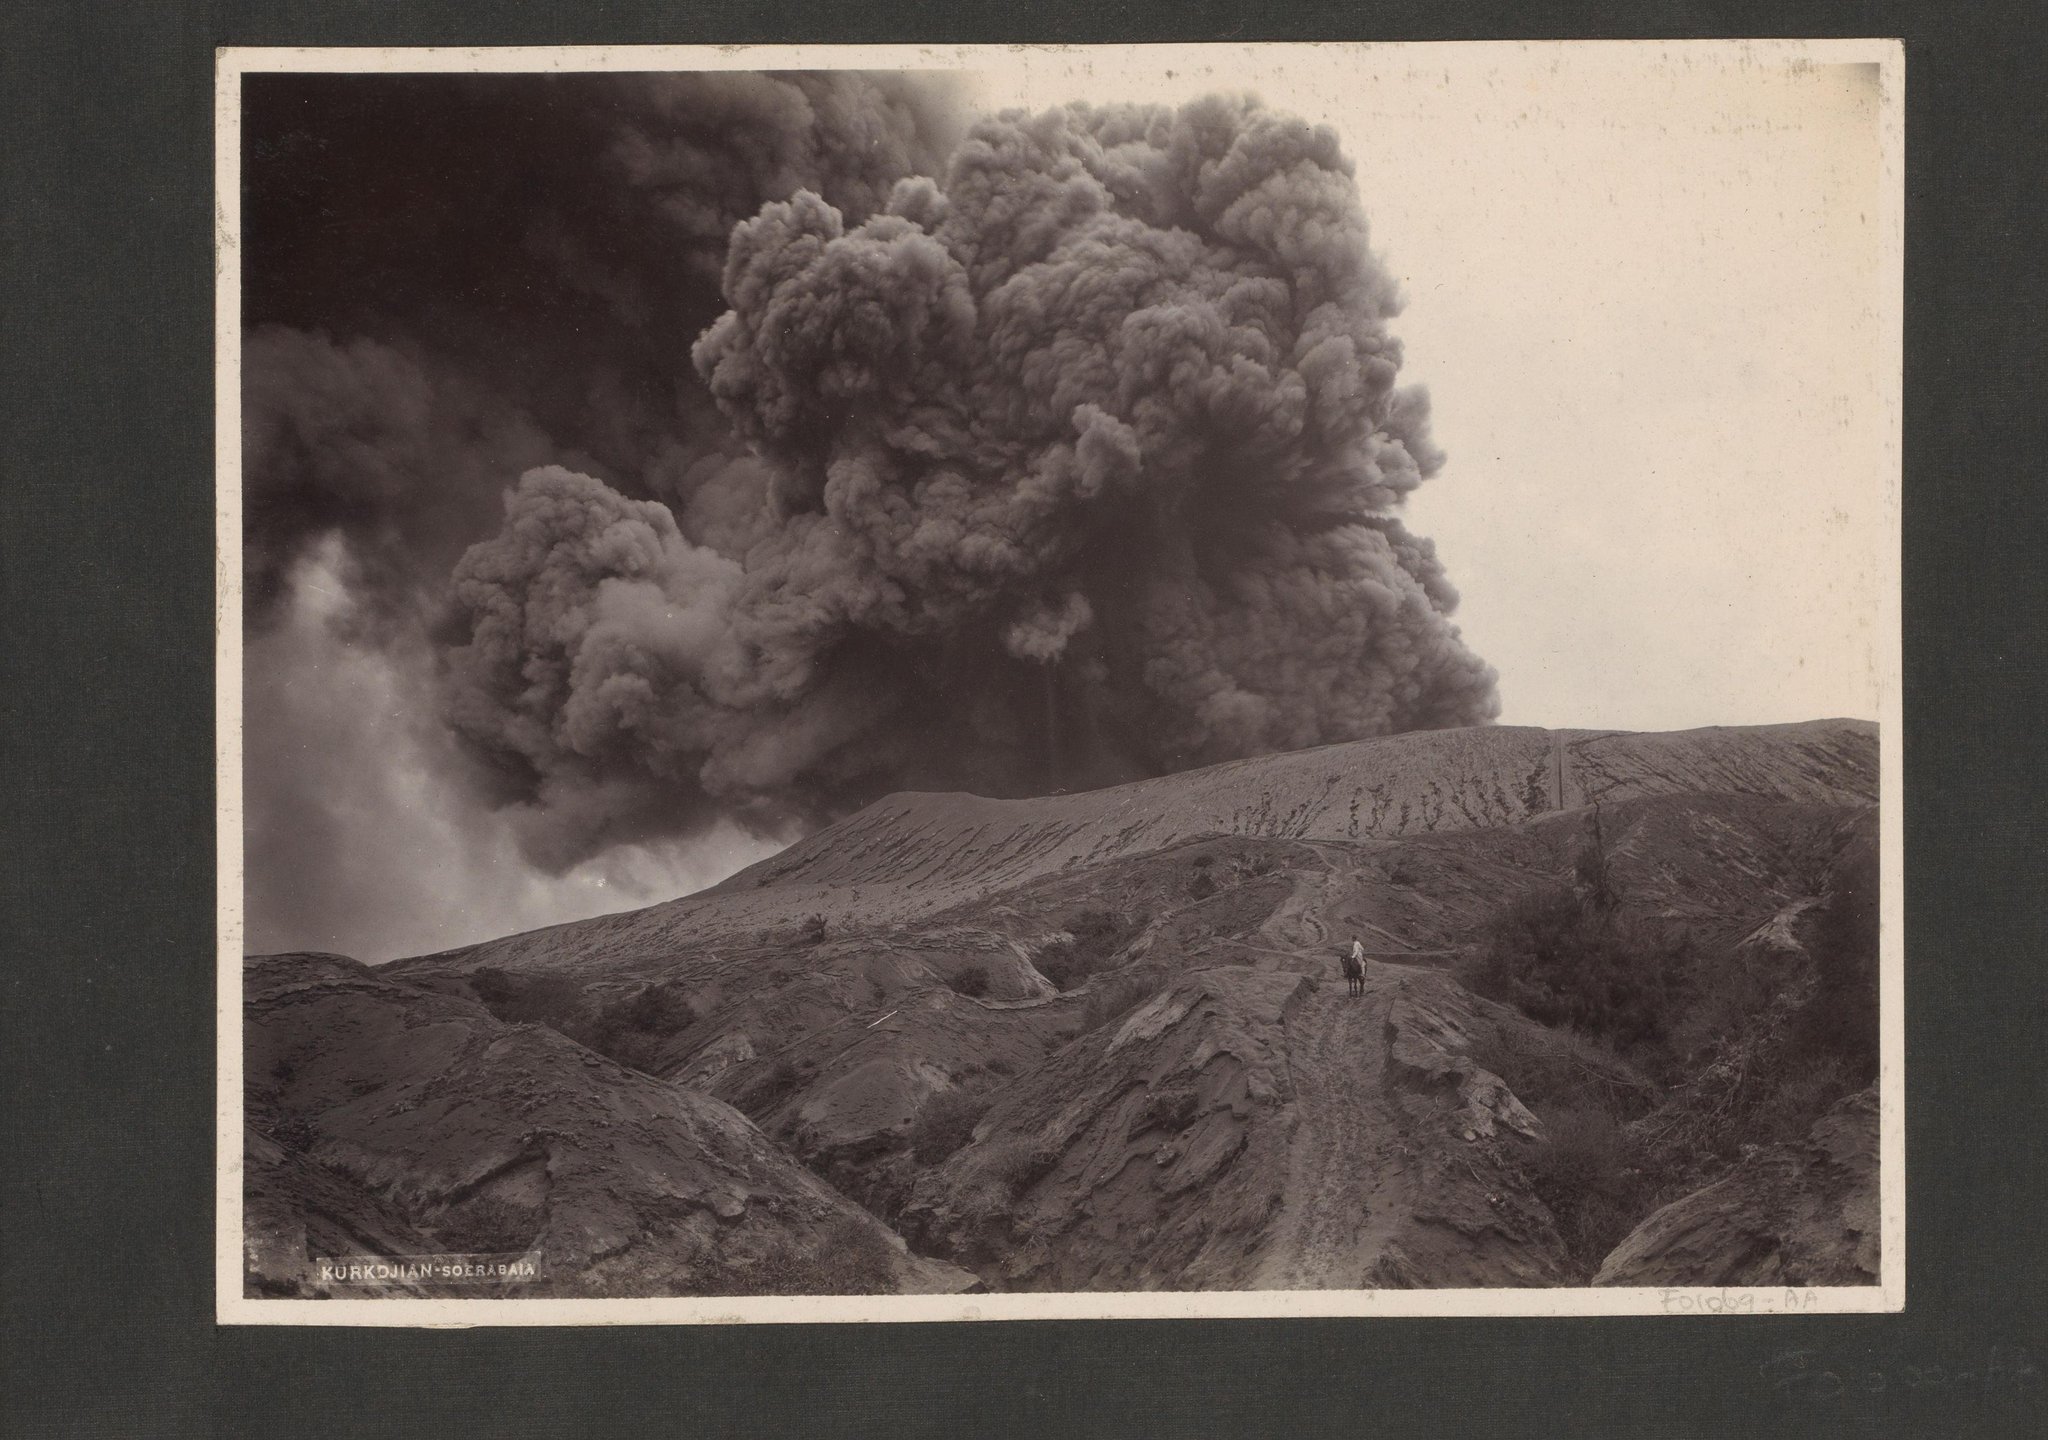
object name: photograph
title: Man met paard bij een rokende vulkaan in Nederlands-Indië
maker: onnes kurkdjian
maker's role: fotograaf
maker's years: 1851-1903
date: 1912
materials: paper, photographic support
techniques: gelatin silver print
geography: dutch east indies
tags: riding a horse, ass, or mule; rider, horseman, volcano, dutch east indies, the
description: Onderdeel van Reisalbum met veertig foto's van Nederlands-Indië.